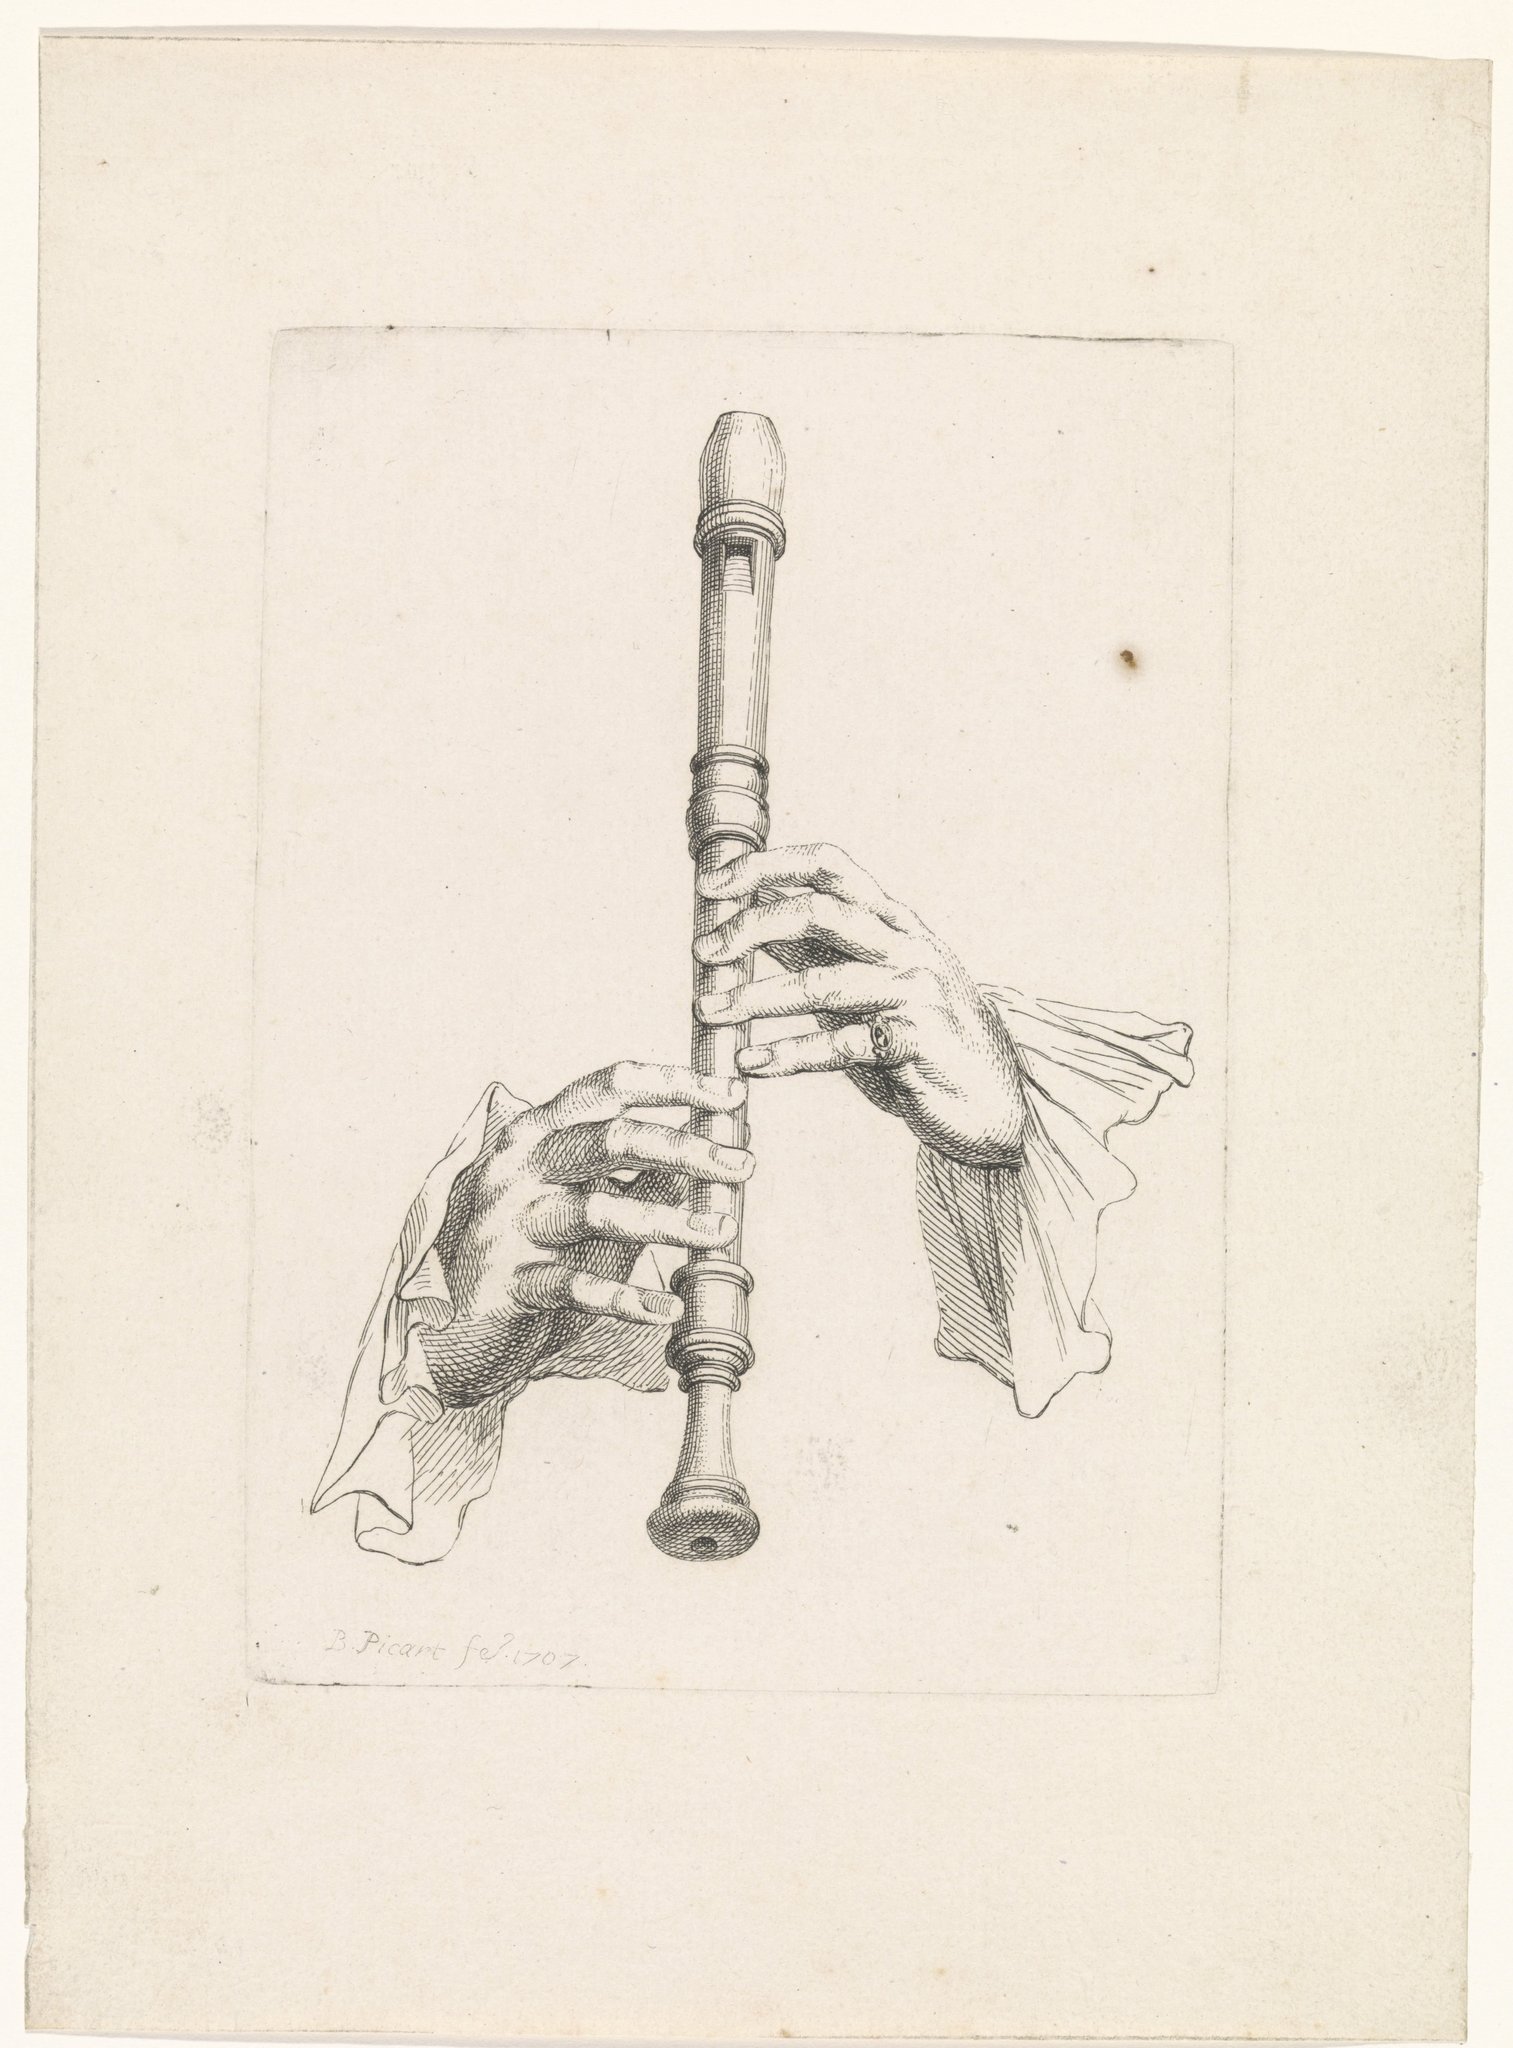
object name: book illustration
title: Positie van de handen op een blokfluit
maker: bernard picart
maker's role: draughtsman, print maker, publisher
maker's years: 1673-1733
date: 1707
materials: paper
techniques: engraving, etching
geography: paris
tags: postures and gestures of hand and fingers, flute, aulos, tibia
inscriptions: collector's mark: Lugt 2228